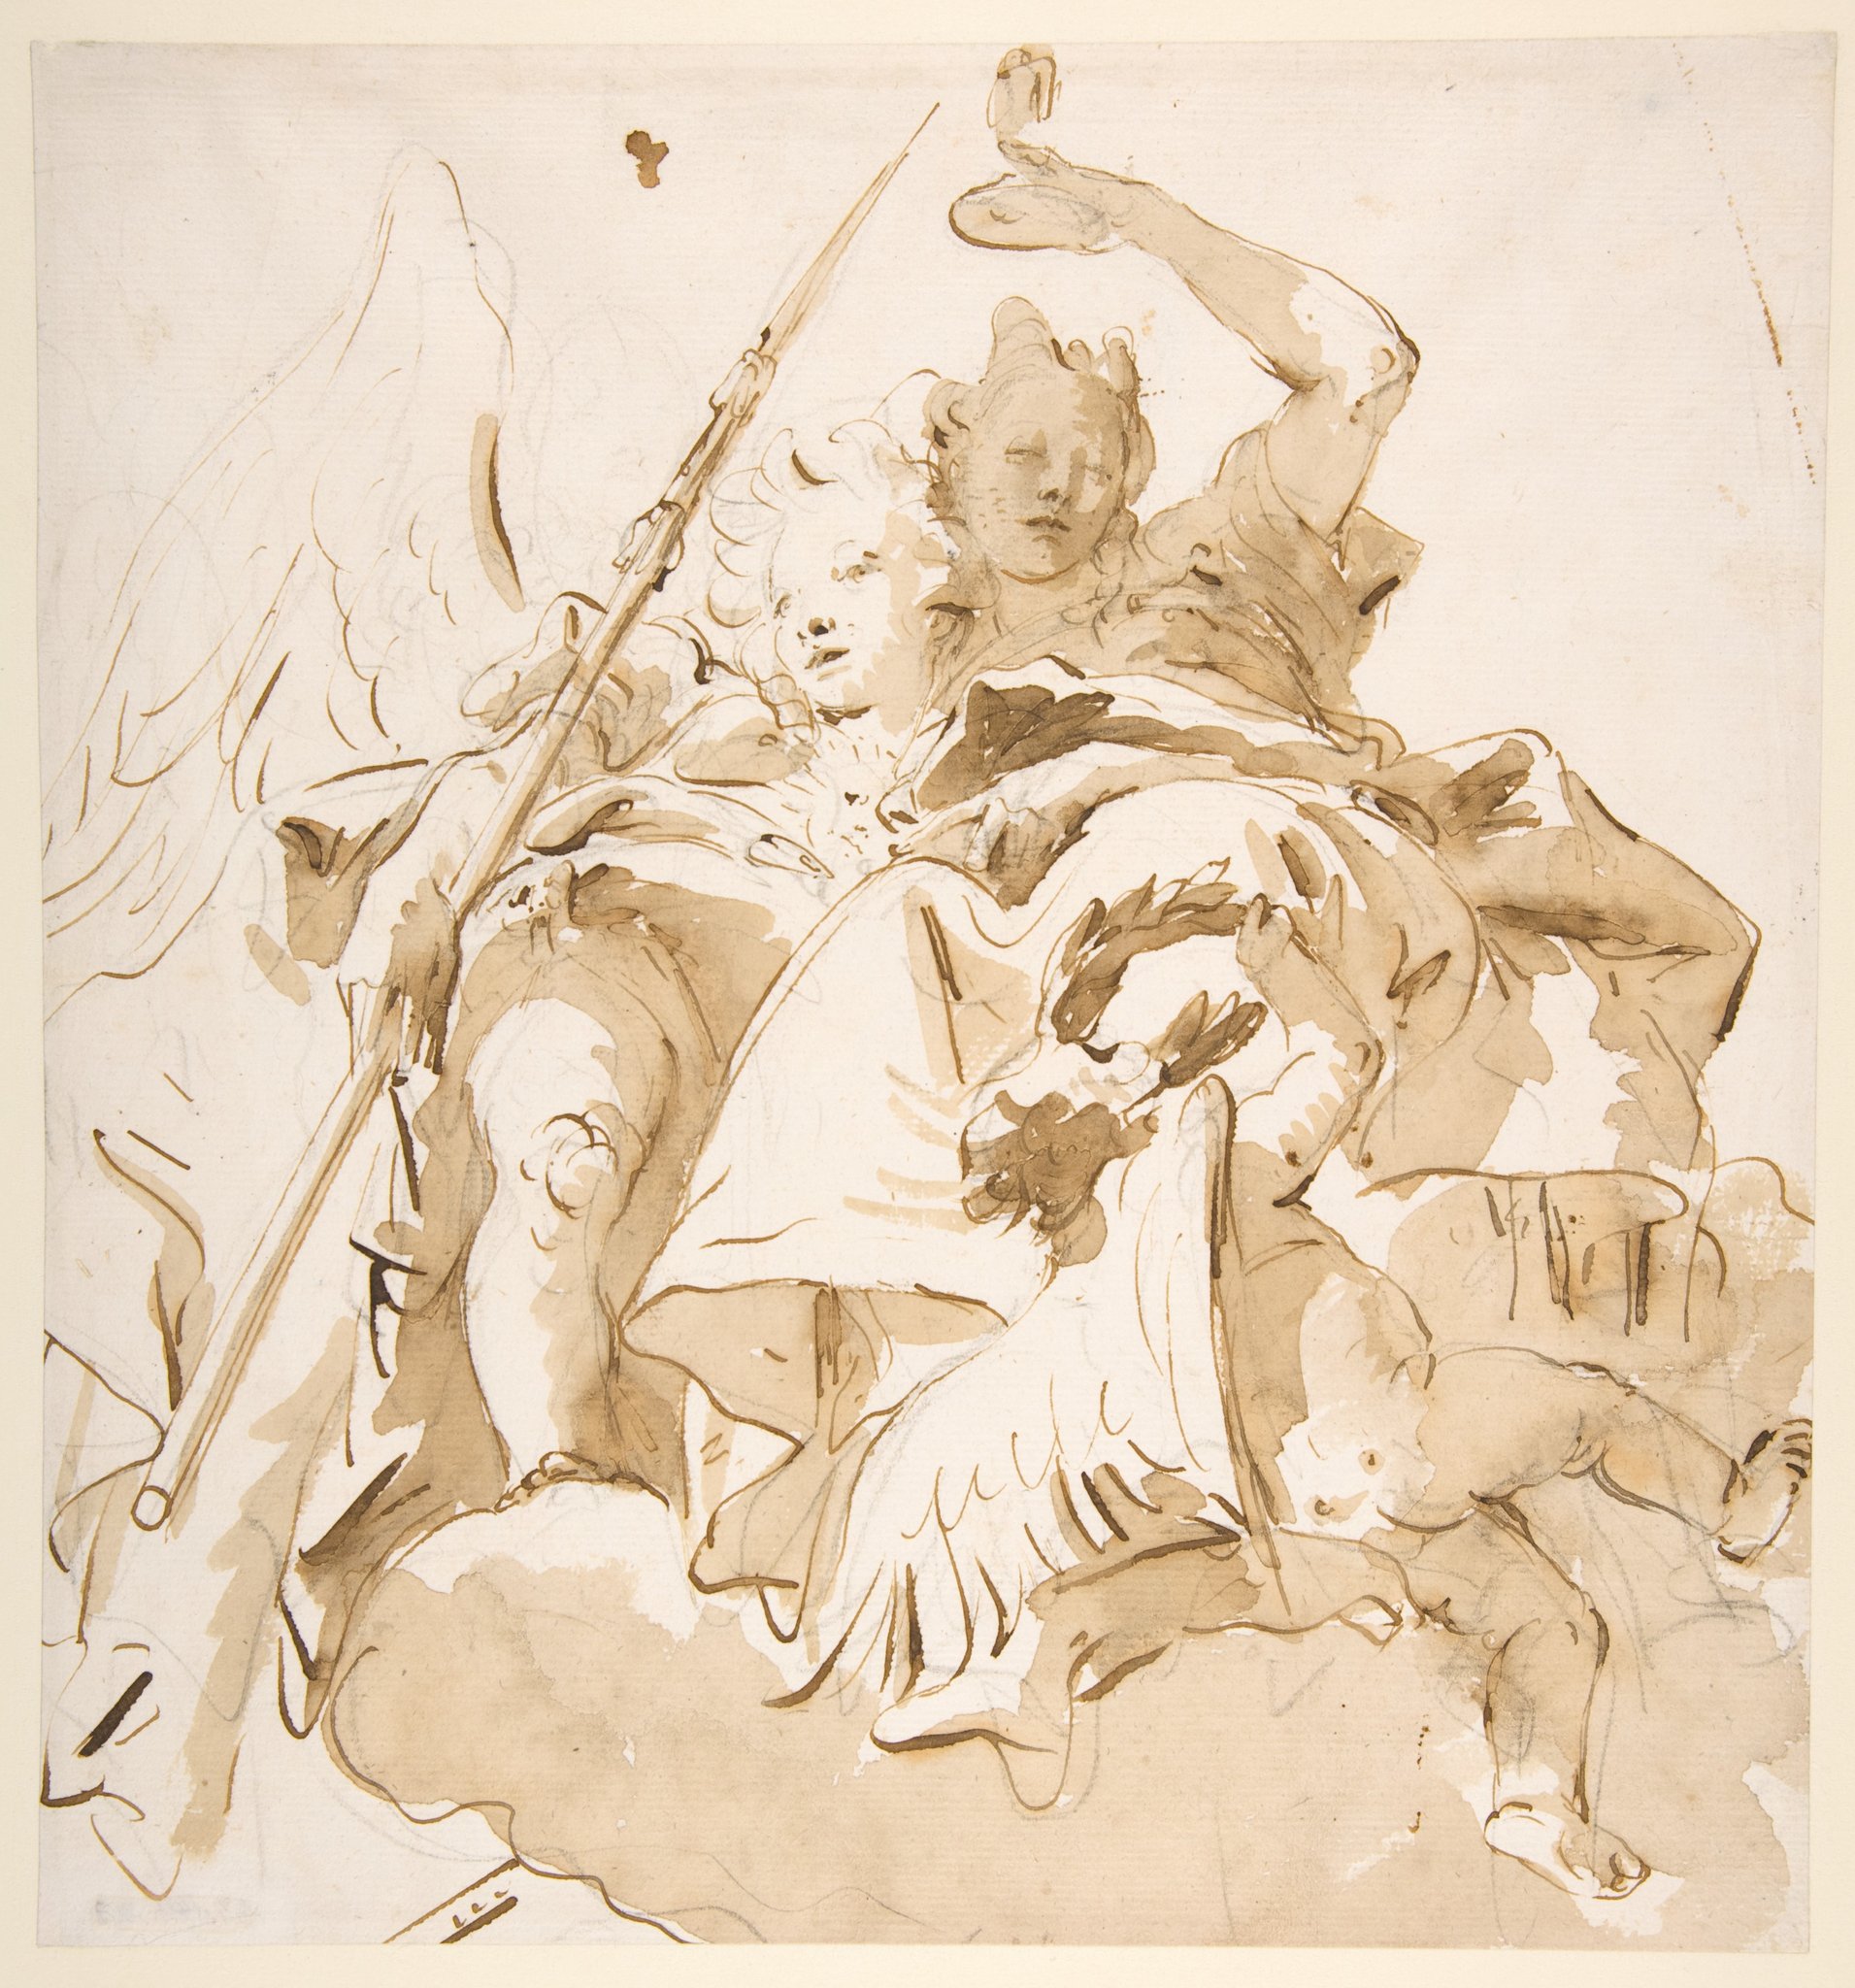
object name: drawing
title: Virtue and Nobility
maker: giovanni battista tiepolo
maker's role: artist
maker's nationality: italian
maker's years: 1696-1770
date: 1696-1770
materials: chalk, ink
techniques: brush, pen, wash